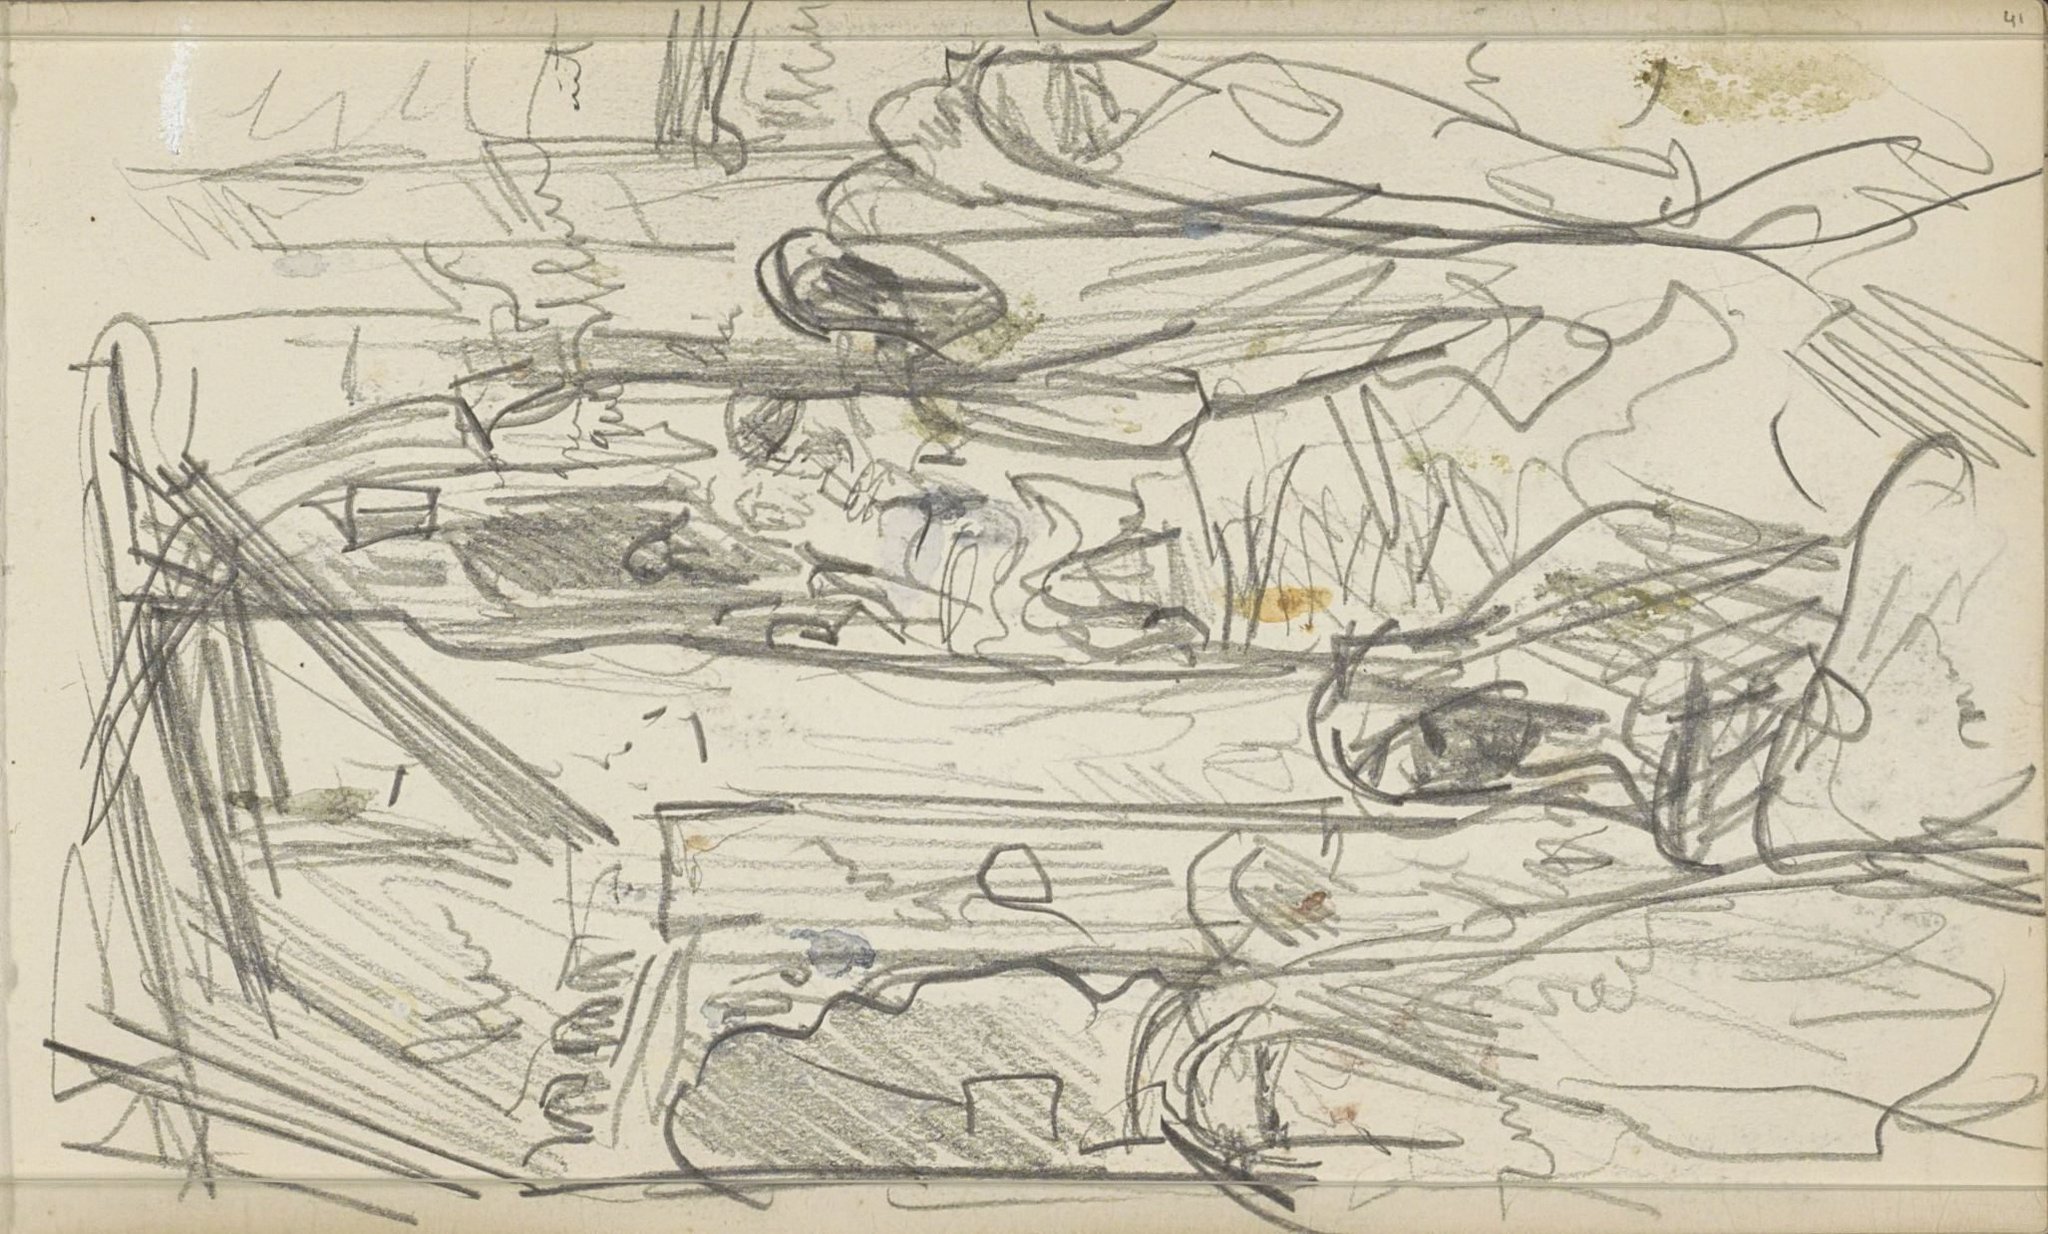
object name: sketchbook leaf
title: Straat met figuren in Biskra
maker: marius bauer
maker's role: draughtsman, print maker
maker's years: 1867-1932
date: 1922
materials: paper, pencil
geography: biskra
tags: street (+ city(-scape) with figures, staffage)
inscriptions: kleurnotitie, handgeschreven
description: Pagina 41 uit een schetsboek met 31 bladen.